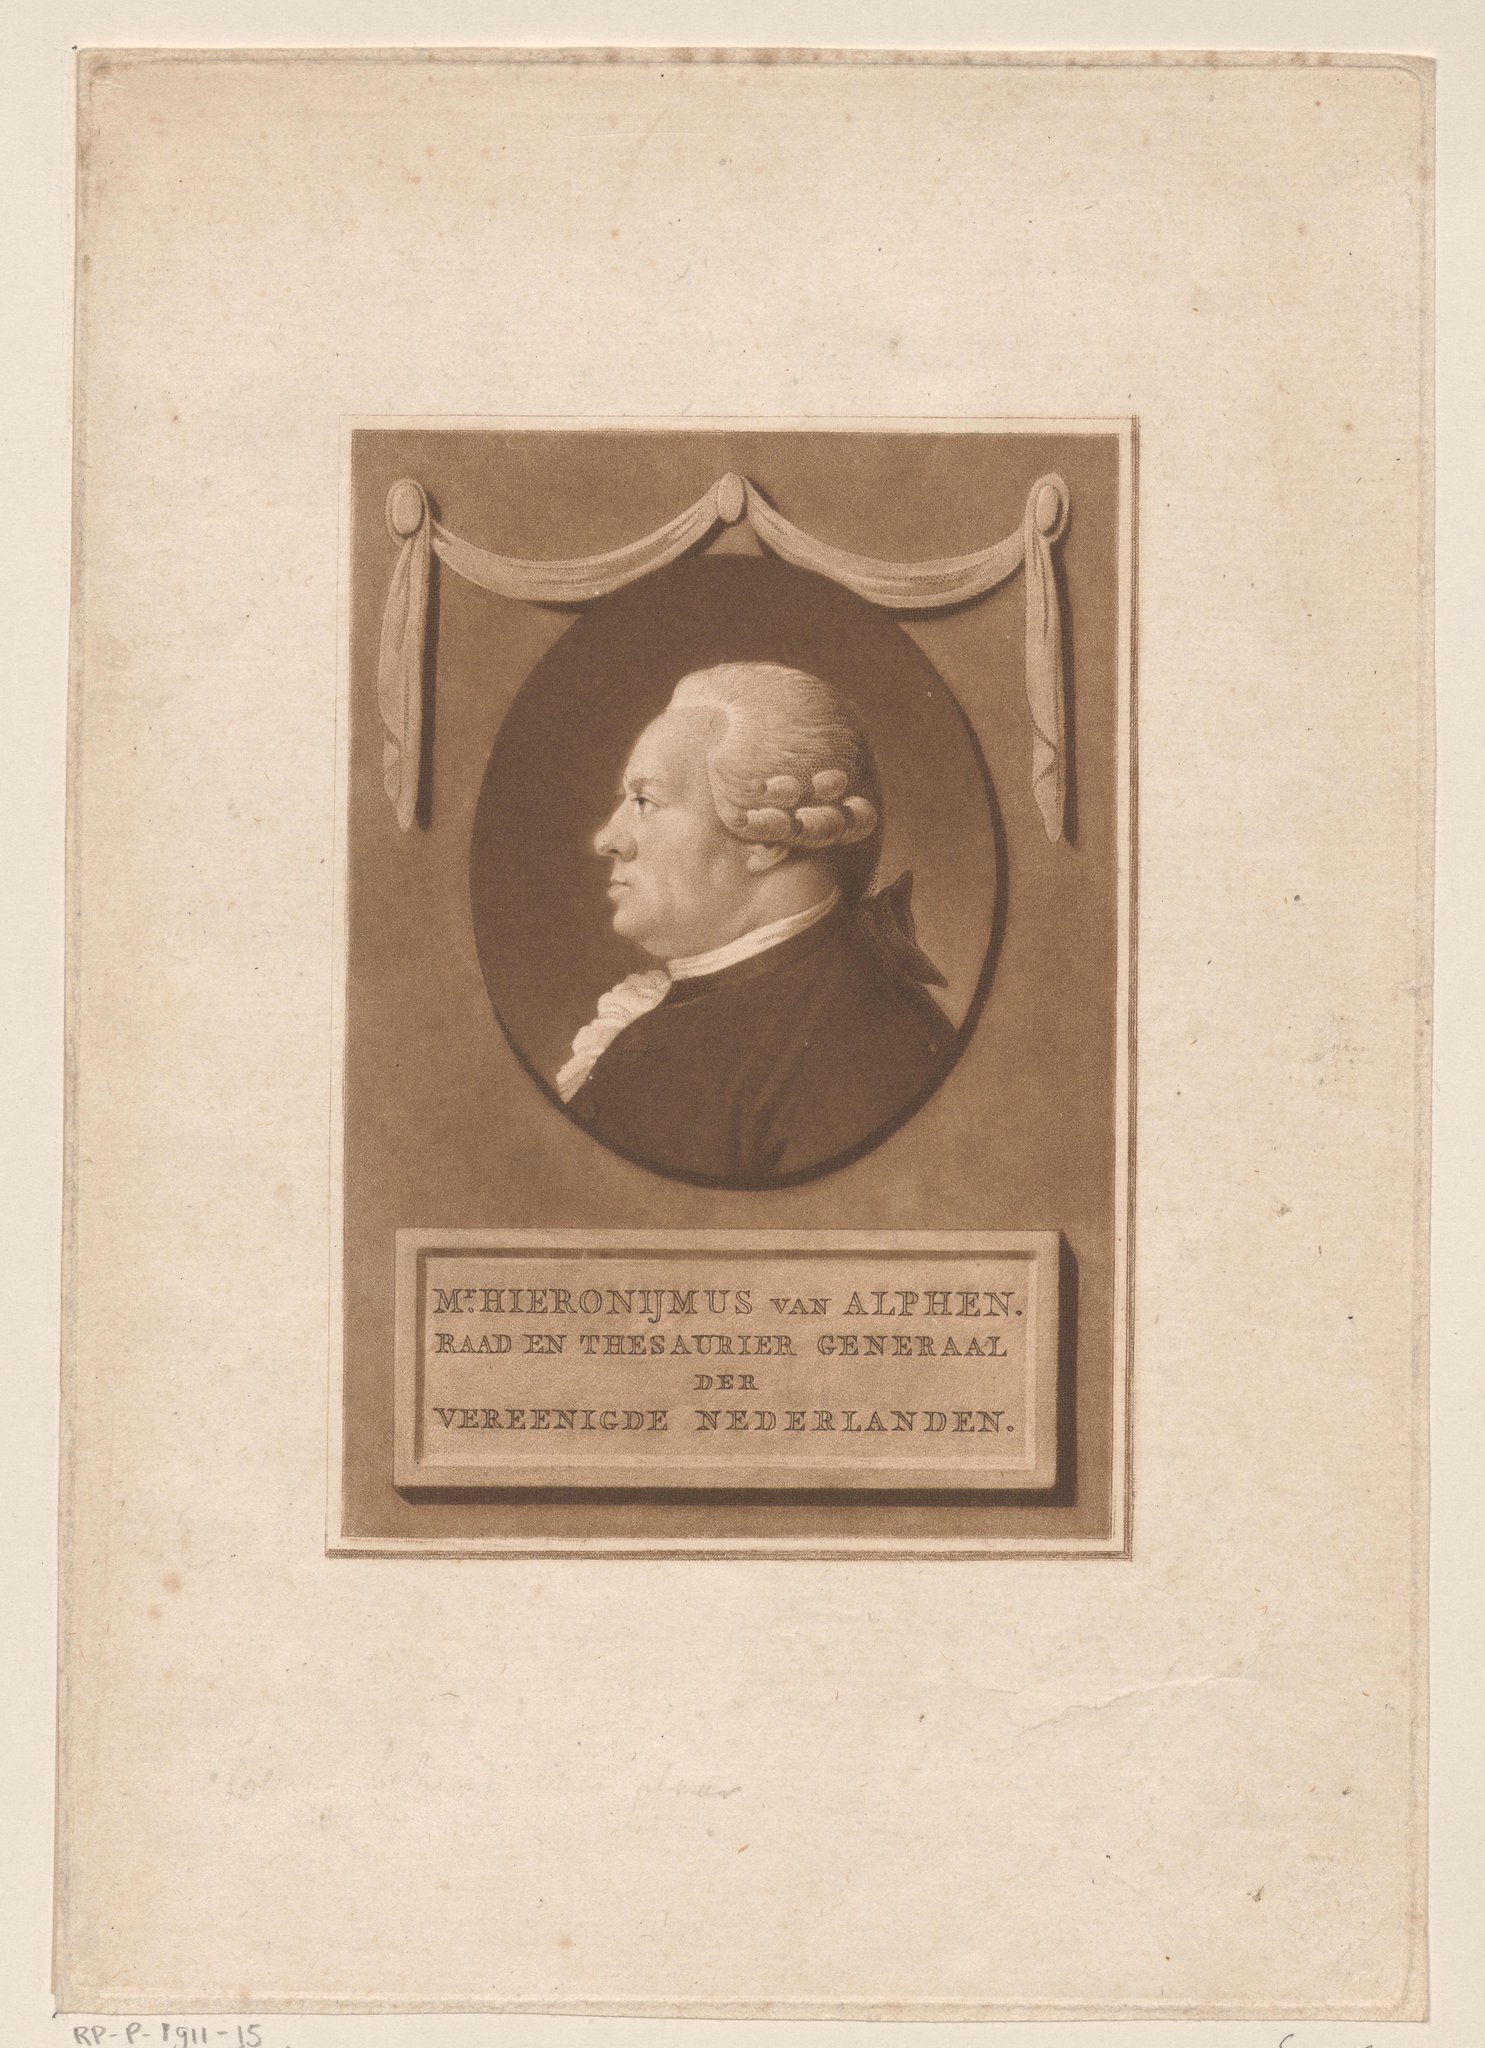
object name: print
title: Portret van Hieronymus van Alphen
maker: Anonymous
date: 1793-1830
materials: paper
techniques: aquatint, etching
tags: gouda, the hague, historical persons, writer, poet, author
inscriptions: collector's mark: Lugt 2228